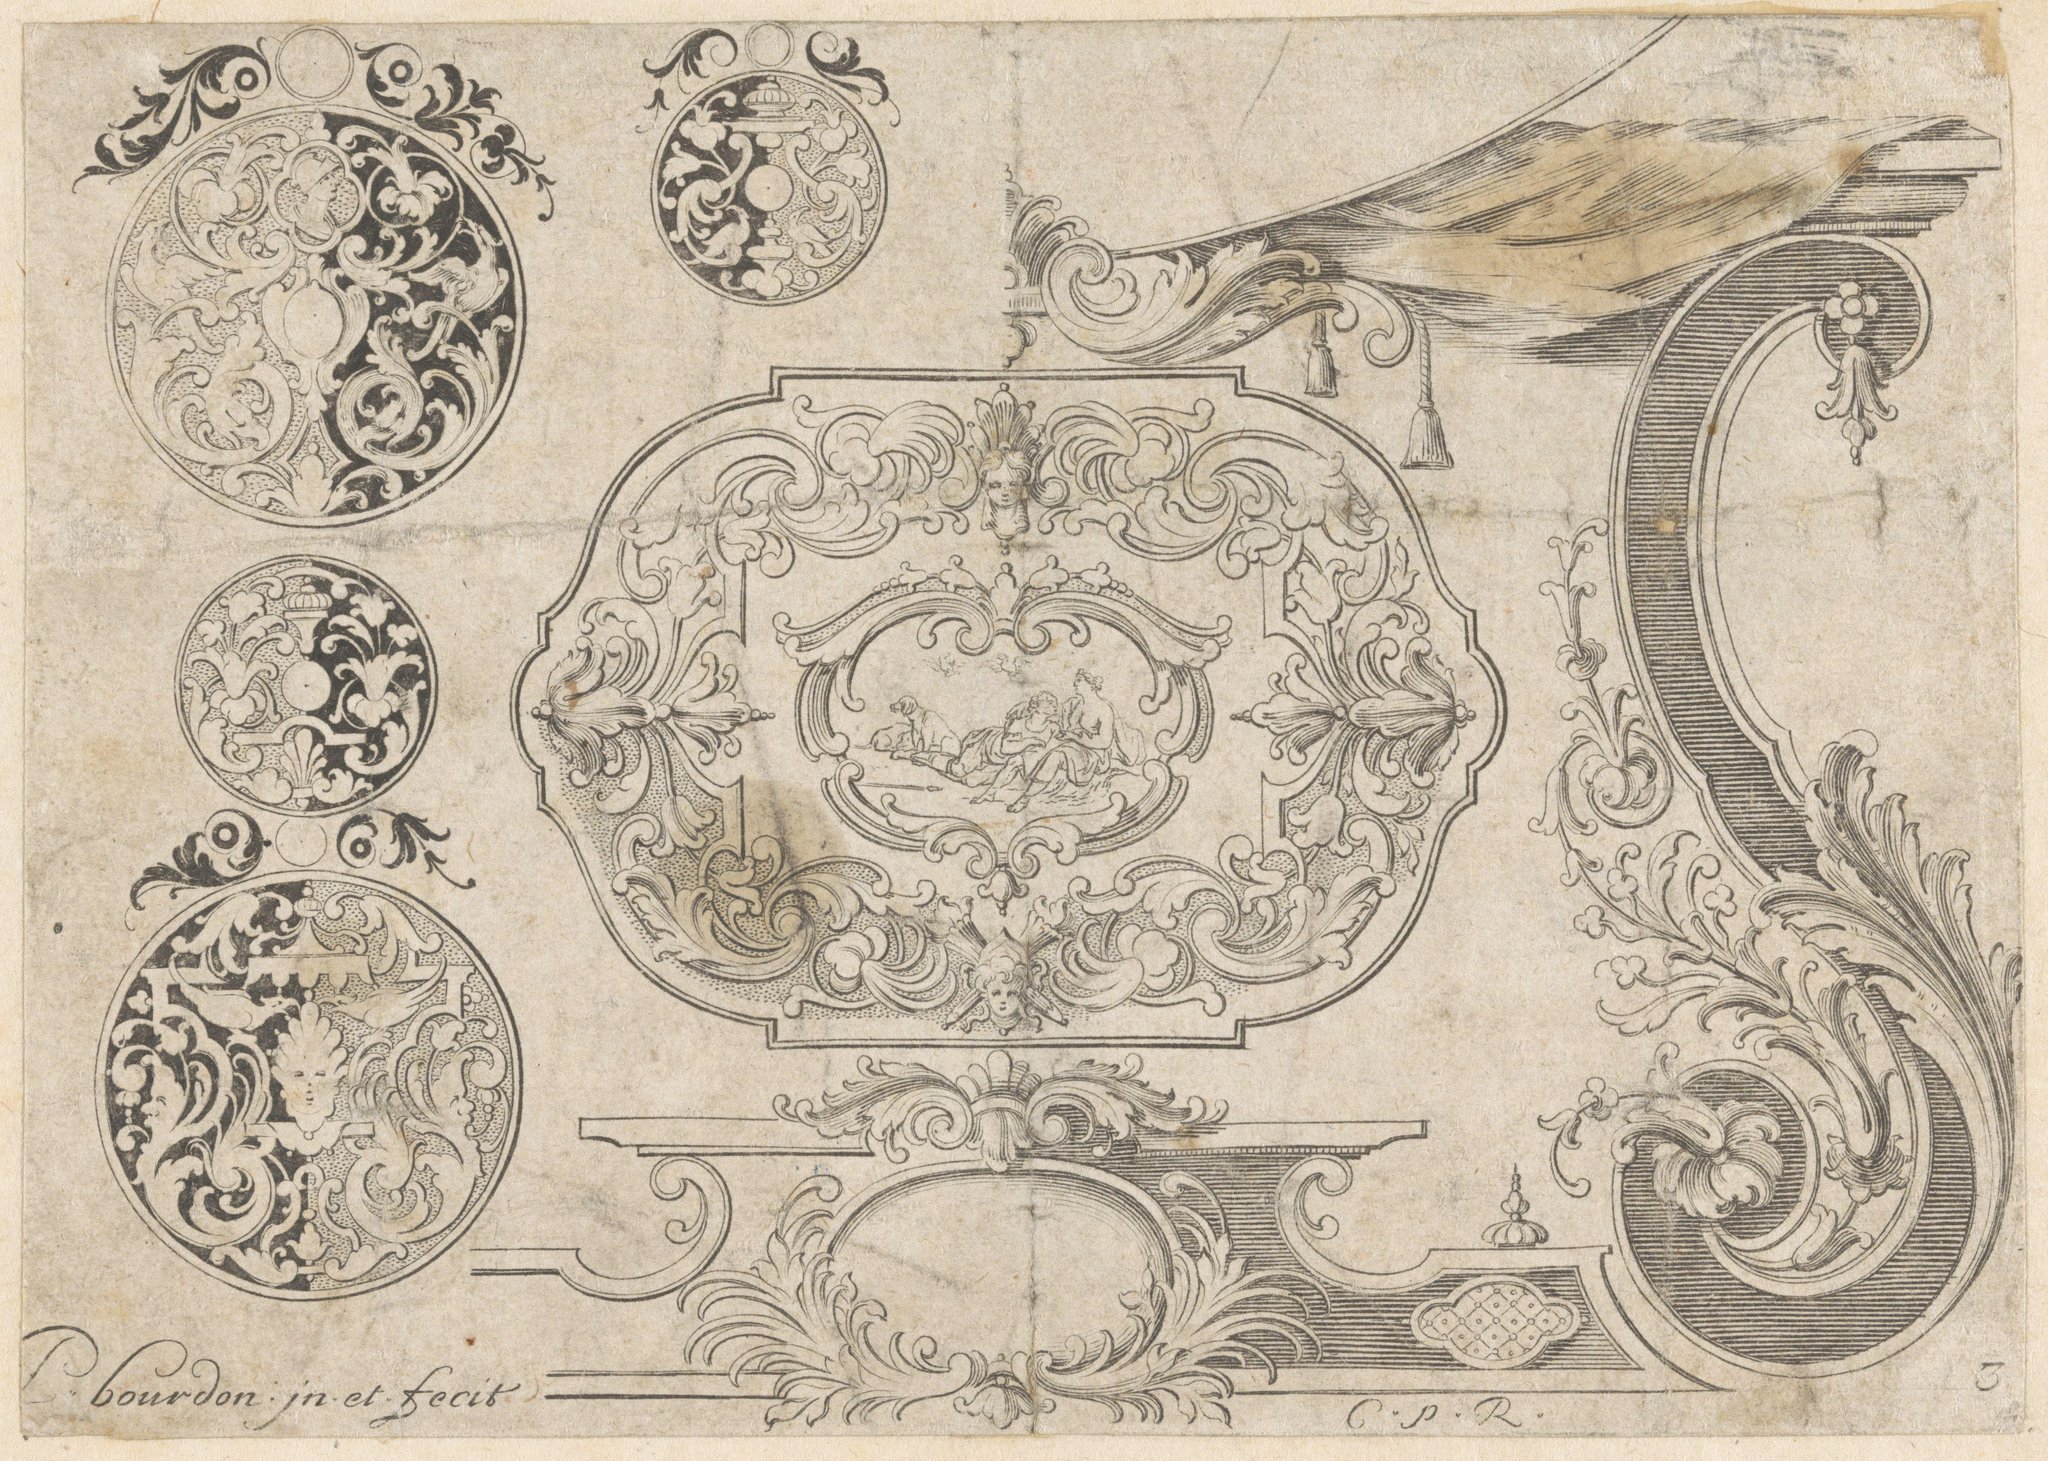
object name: print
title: Livre Premier: Essais de gravure par Pierre Bourdon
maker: pierre bourdon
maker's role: print maker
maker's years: 1656-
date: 1703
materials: paper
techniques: engraving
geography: paris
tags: ornaments ~ art, watch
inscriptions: collector's mark: Lugt 2228, signature: ‘P. bourdon in et fecit’, privilege: ‘C.P.R.’, number: ‘3’, collector's mark: Lugt 2760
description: Blad uit serie van zeven van ontwerpen voor horlogemakers, goudsmeden, beeldhouwers en graveurs.